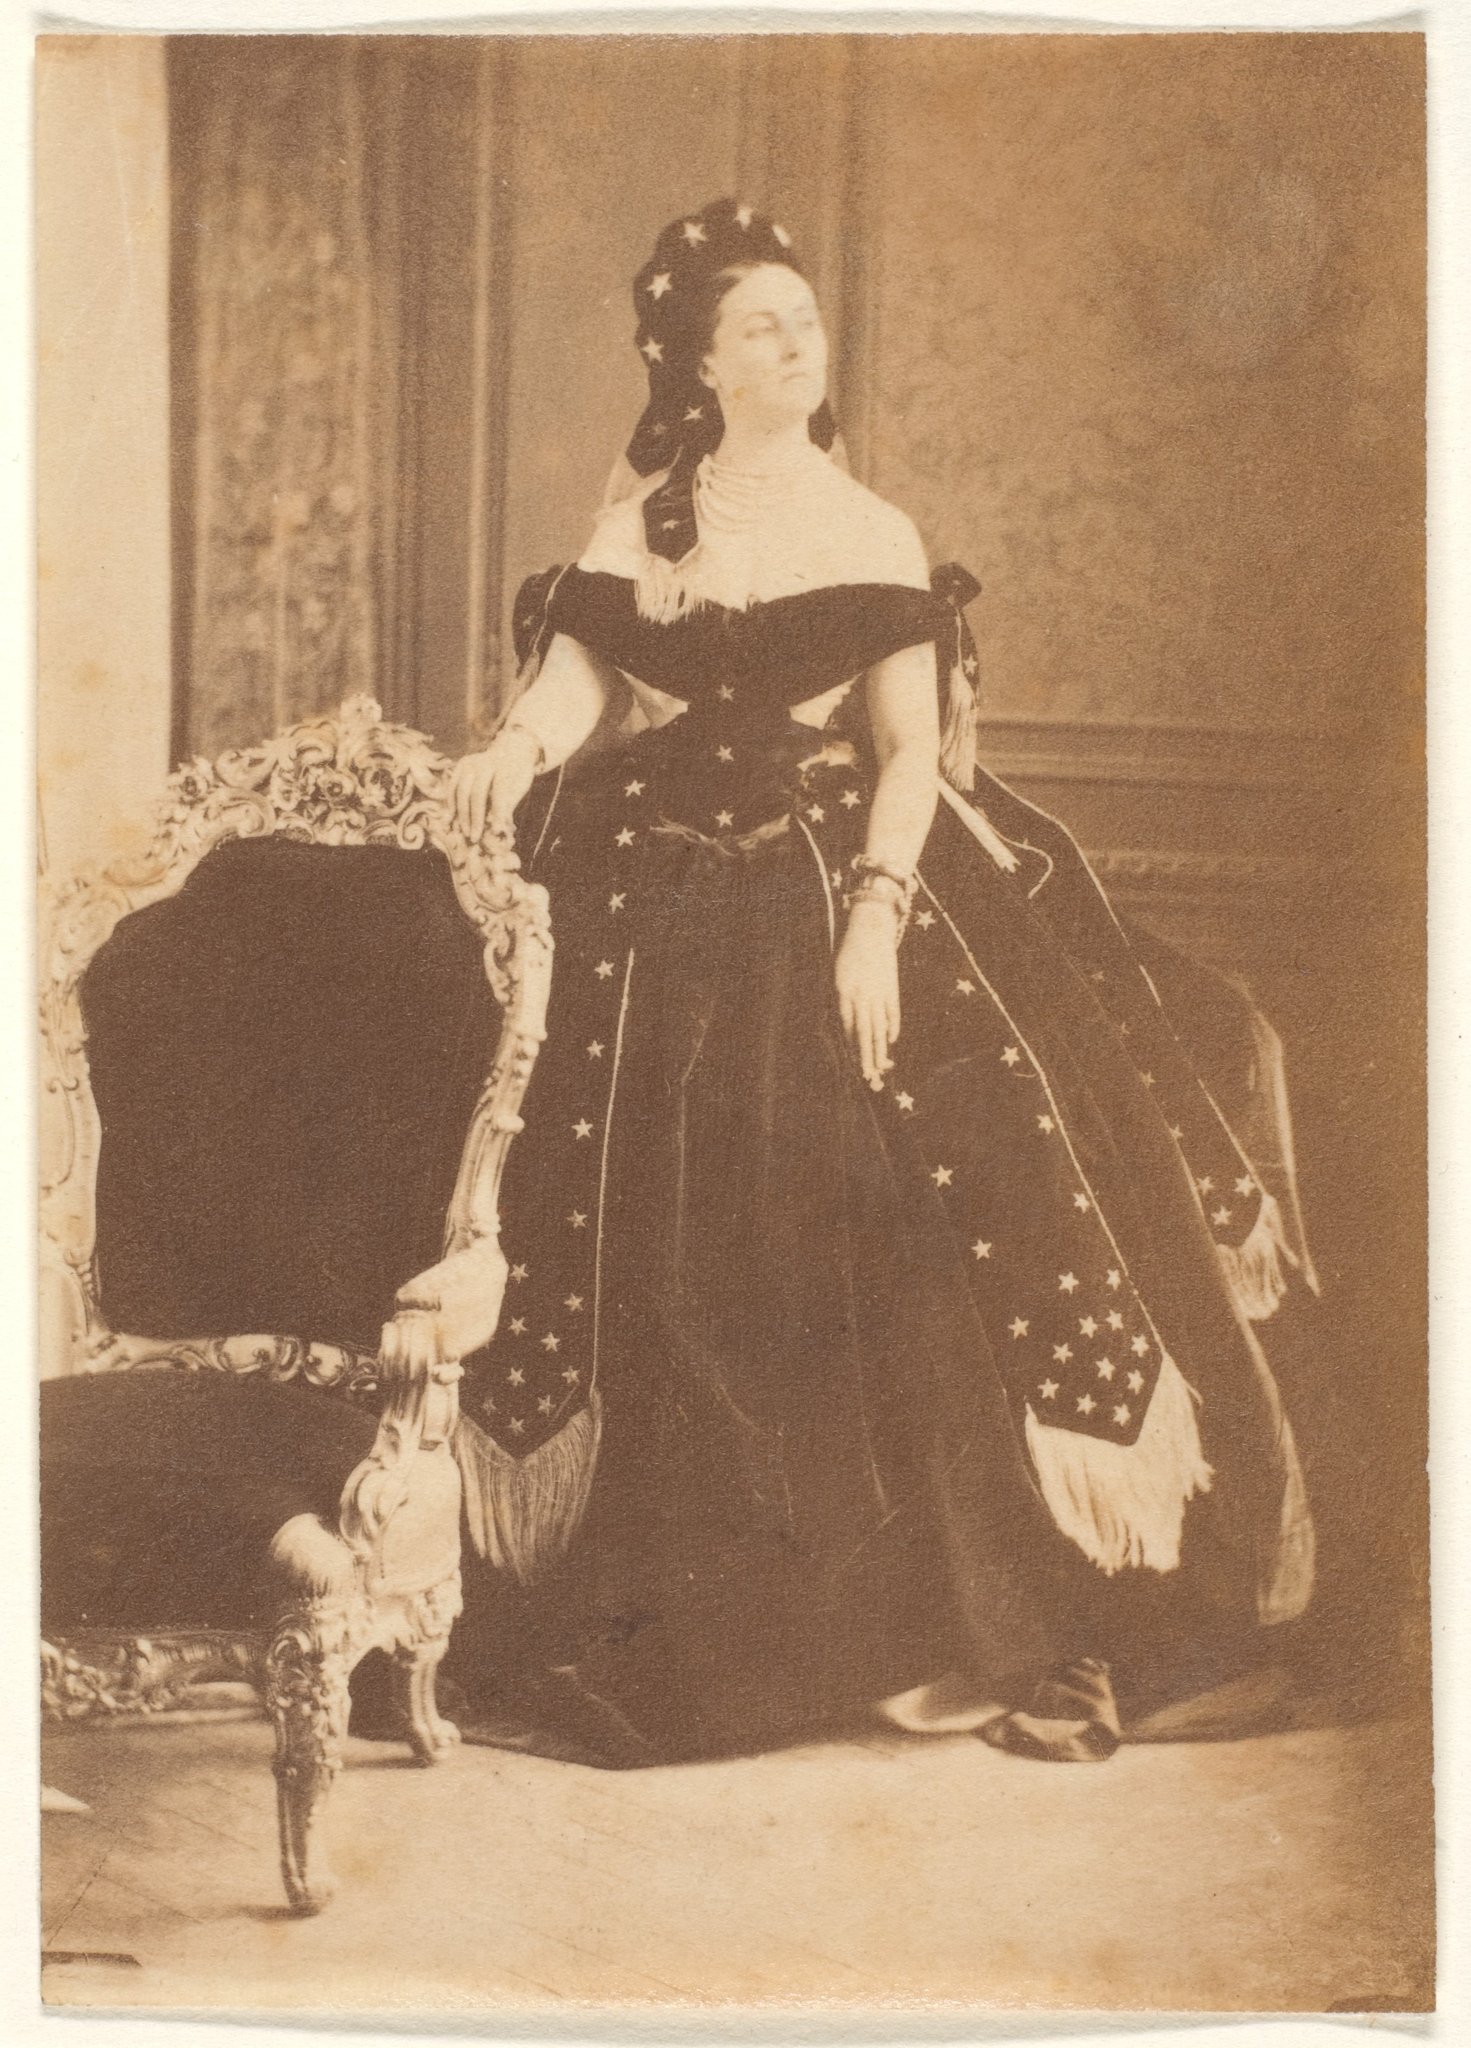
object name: photograph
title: Stella (autre)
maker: pierre-louis pierson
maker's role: artist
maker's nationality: french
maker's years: 1822-1913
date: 1860-1869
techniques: albumen silver print, glass negative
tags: portraits,women